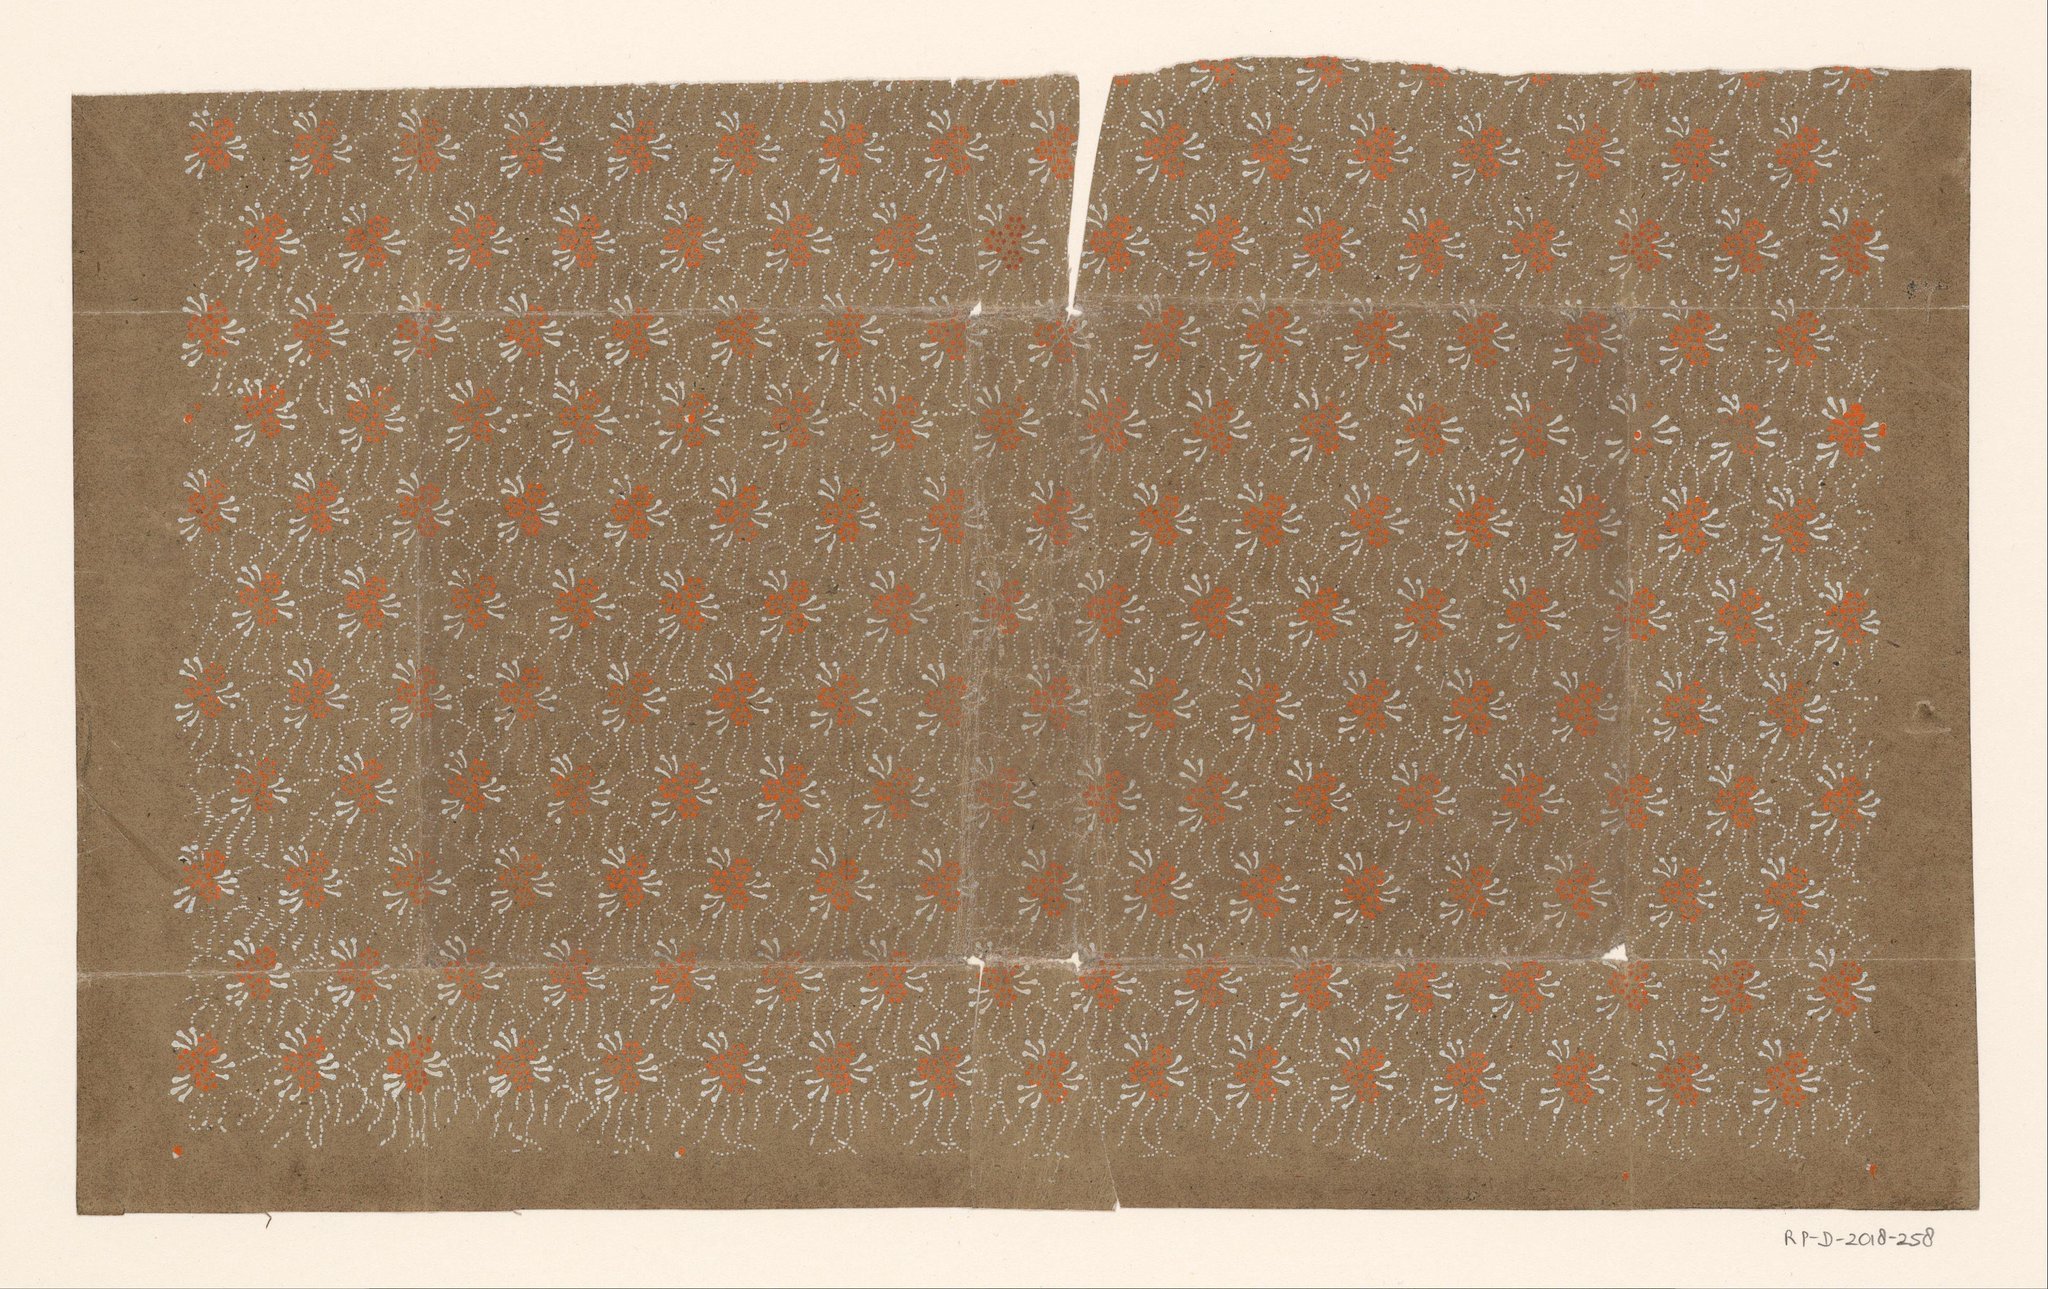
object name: wrapper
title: Blad met strooipatroon van druiventros tussen stippellijnen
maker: Anonymous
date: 1750-1900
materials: lacquer, paper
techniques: printing block, lacquer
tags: ornament derived from plant forms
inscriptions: collector's mark: Lugt 2228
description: Blad met strooipatroon van druiventros tussen stippellijnen. Gebruikt als omslag, met insnijdingen bij de rug.